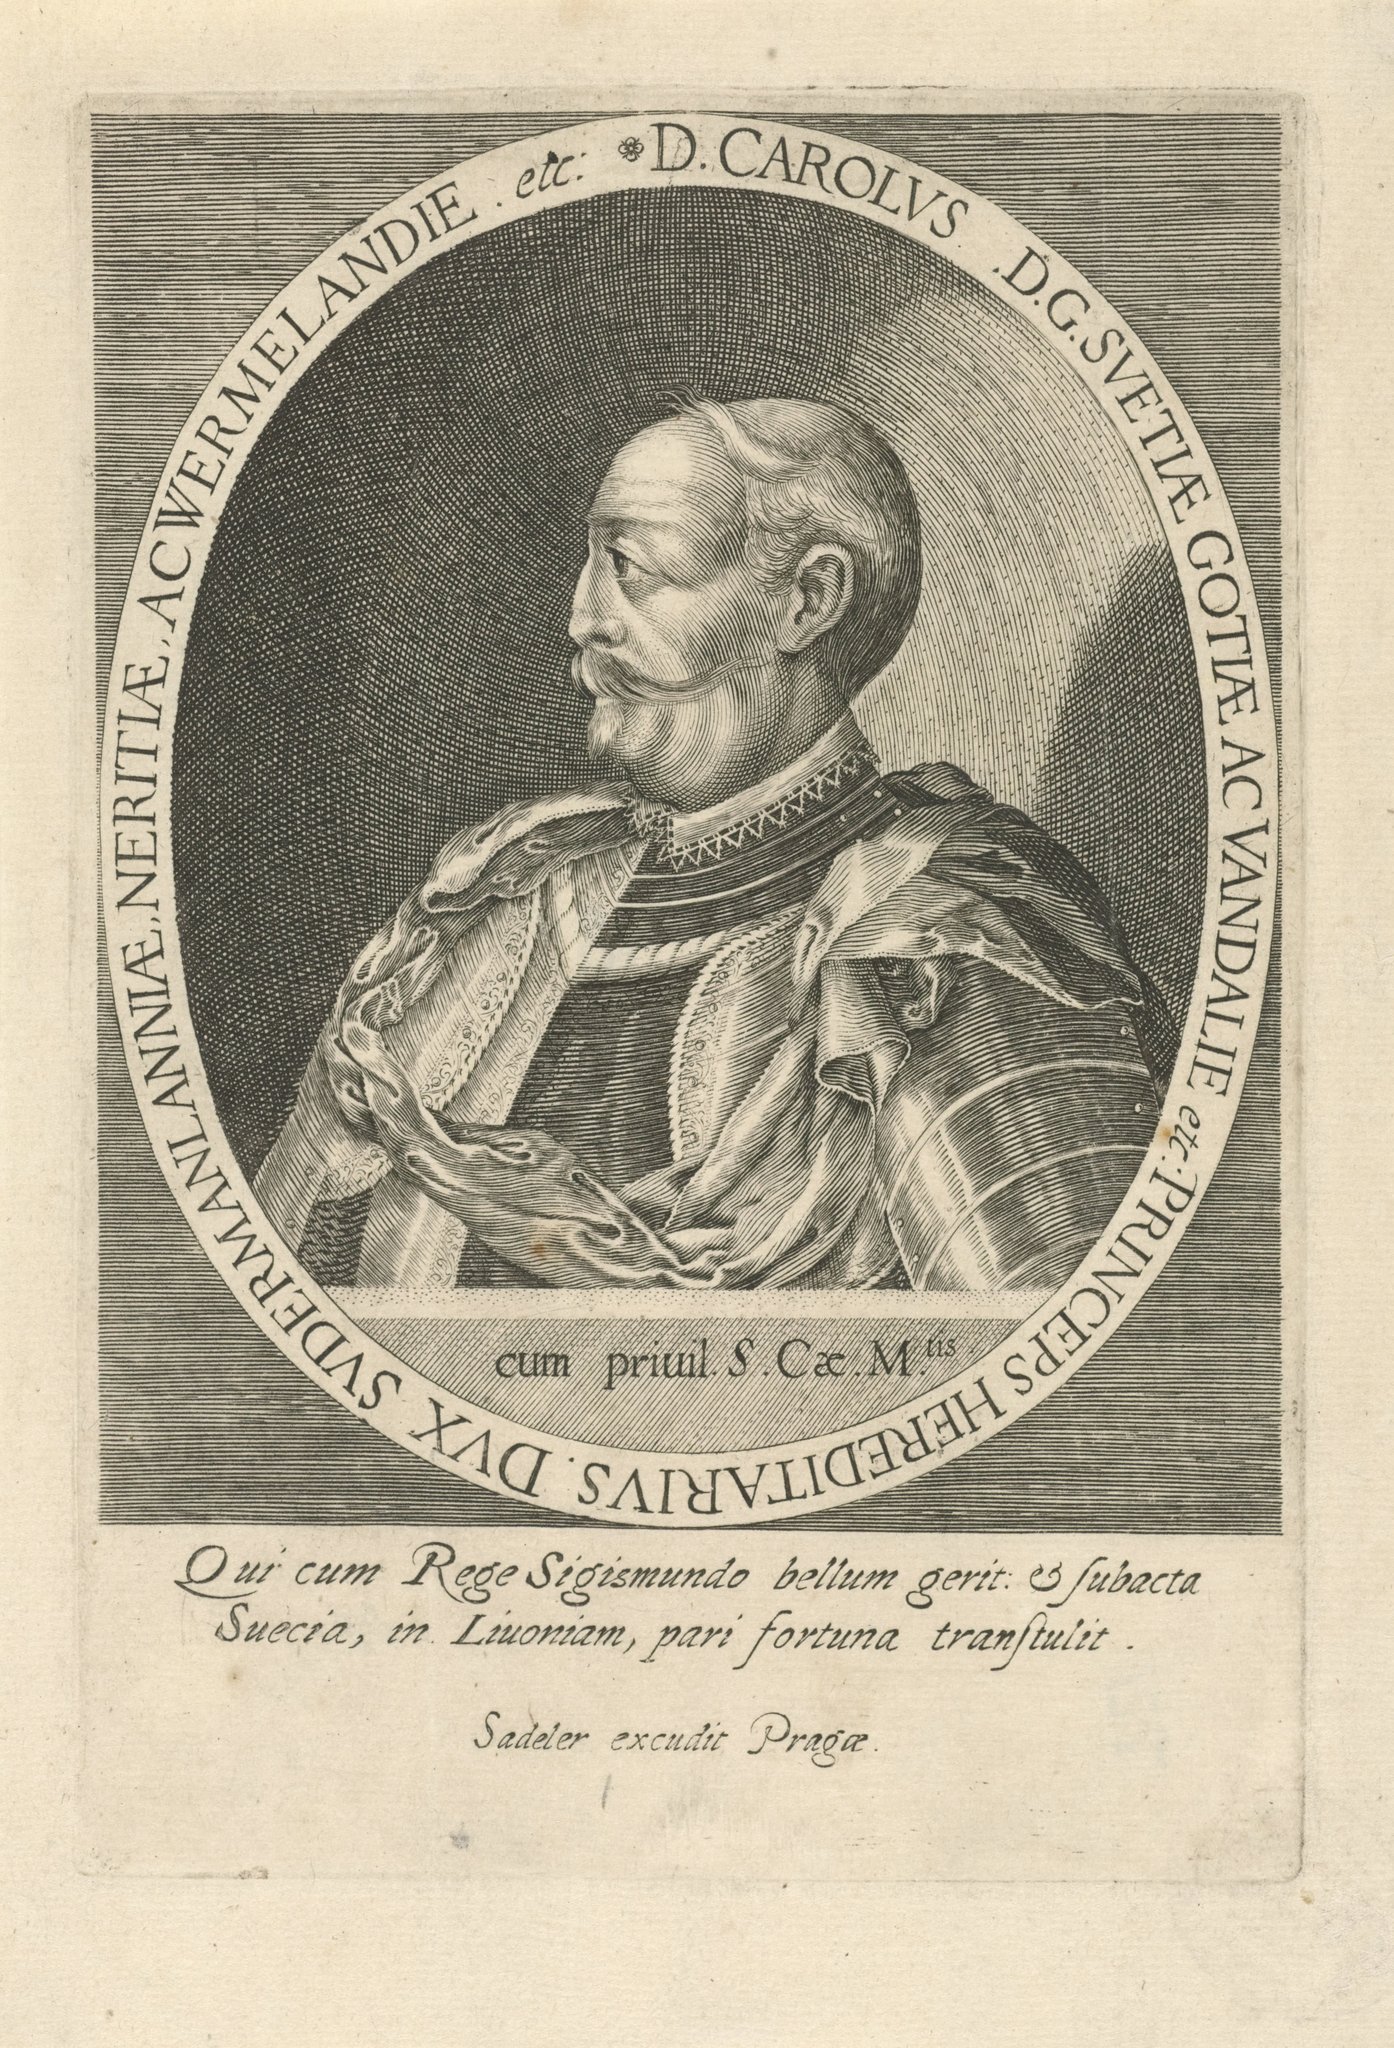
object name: print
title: Portret van Karel IX van Zweden als hertog van Södermanland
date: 1604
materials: paper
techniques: engraving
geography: prague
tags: koning, karel ix (koning van zweden)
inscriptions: collector's mark: Lugt 240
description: Portret van Karel IX van Zweden, geportretteerd toen hij nog hertog van Södermanland was. De prent heeft een Latijns onderschrift.